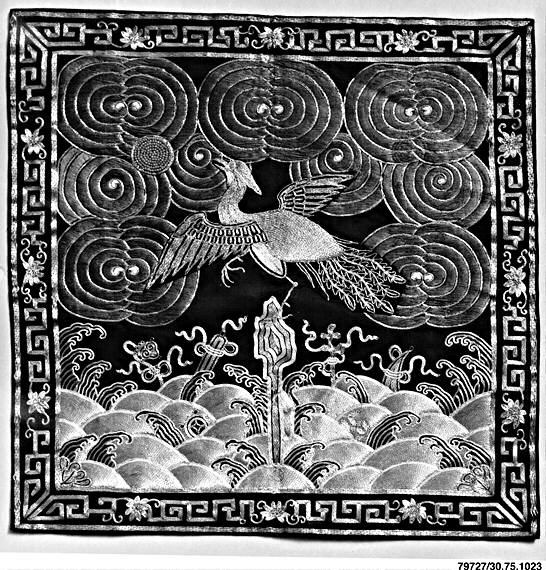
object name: rank badge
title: Rank Badge with Silver Pheasant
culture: chinese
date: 1801-1900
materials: metal thread, silk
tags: pheasants